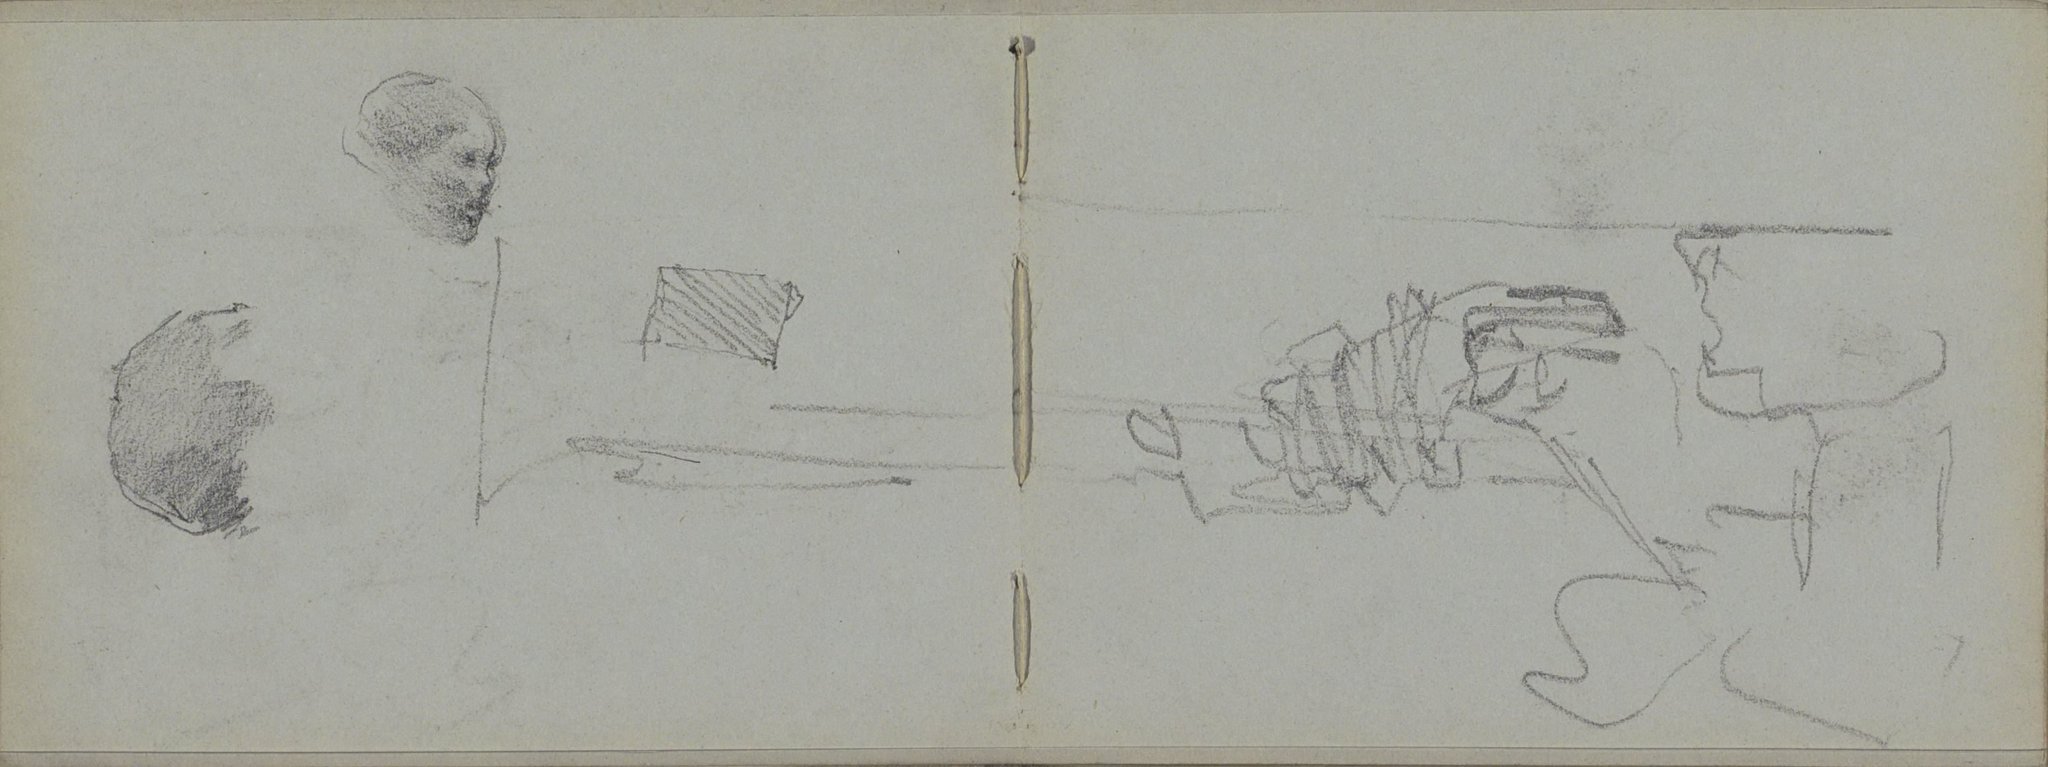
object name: sketchbook leaf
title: Studieblad, onder andere met een vrouwenkop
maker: george clausen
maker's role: draughtsman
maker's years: 1852-1912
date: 1874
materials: paper, pencil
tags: head (human), adult woman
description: Blad 14 verso en 15 recto uit een schetsboek met 37 bladen.